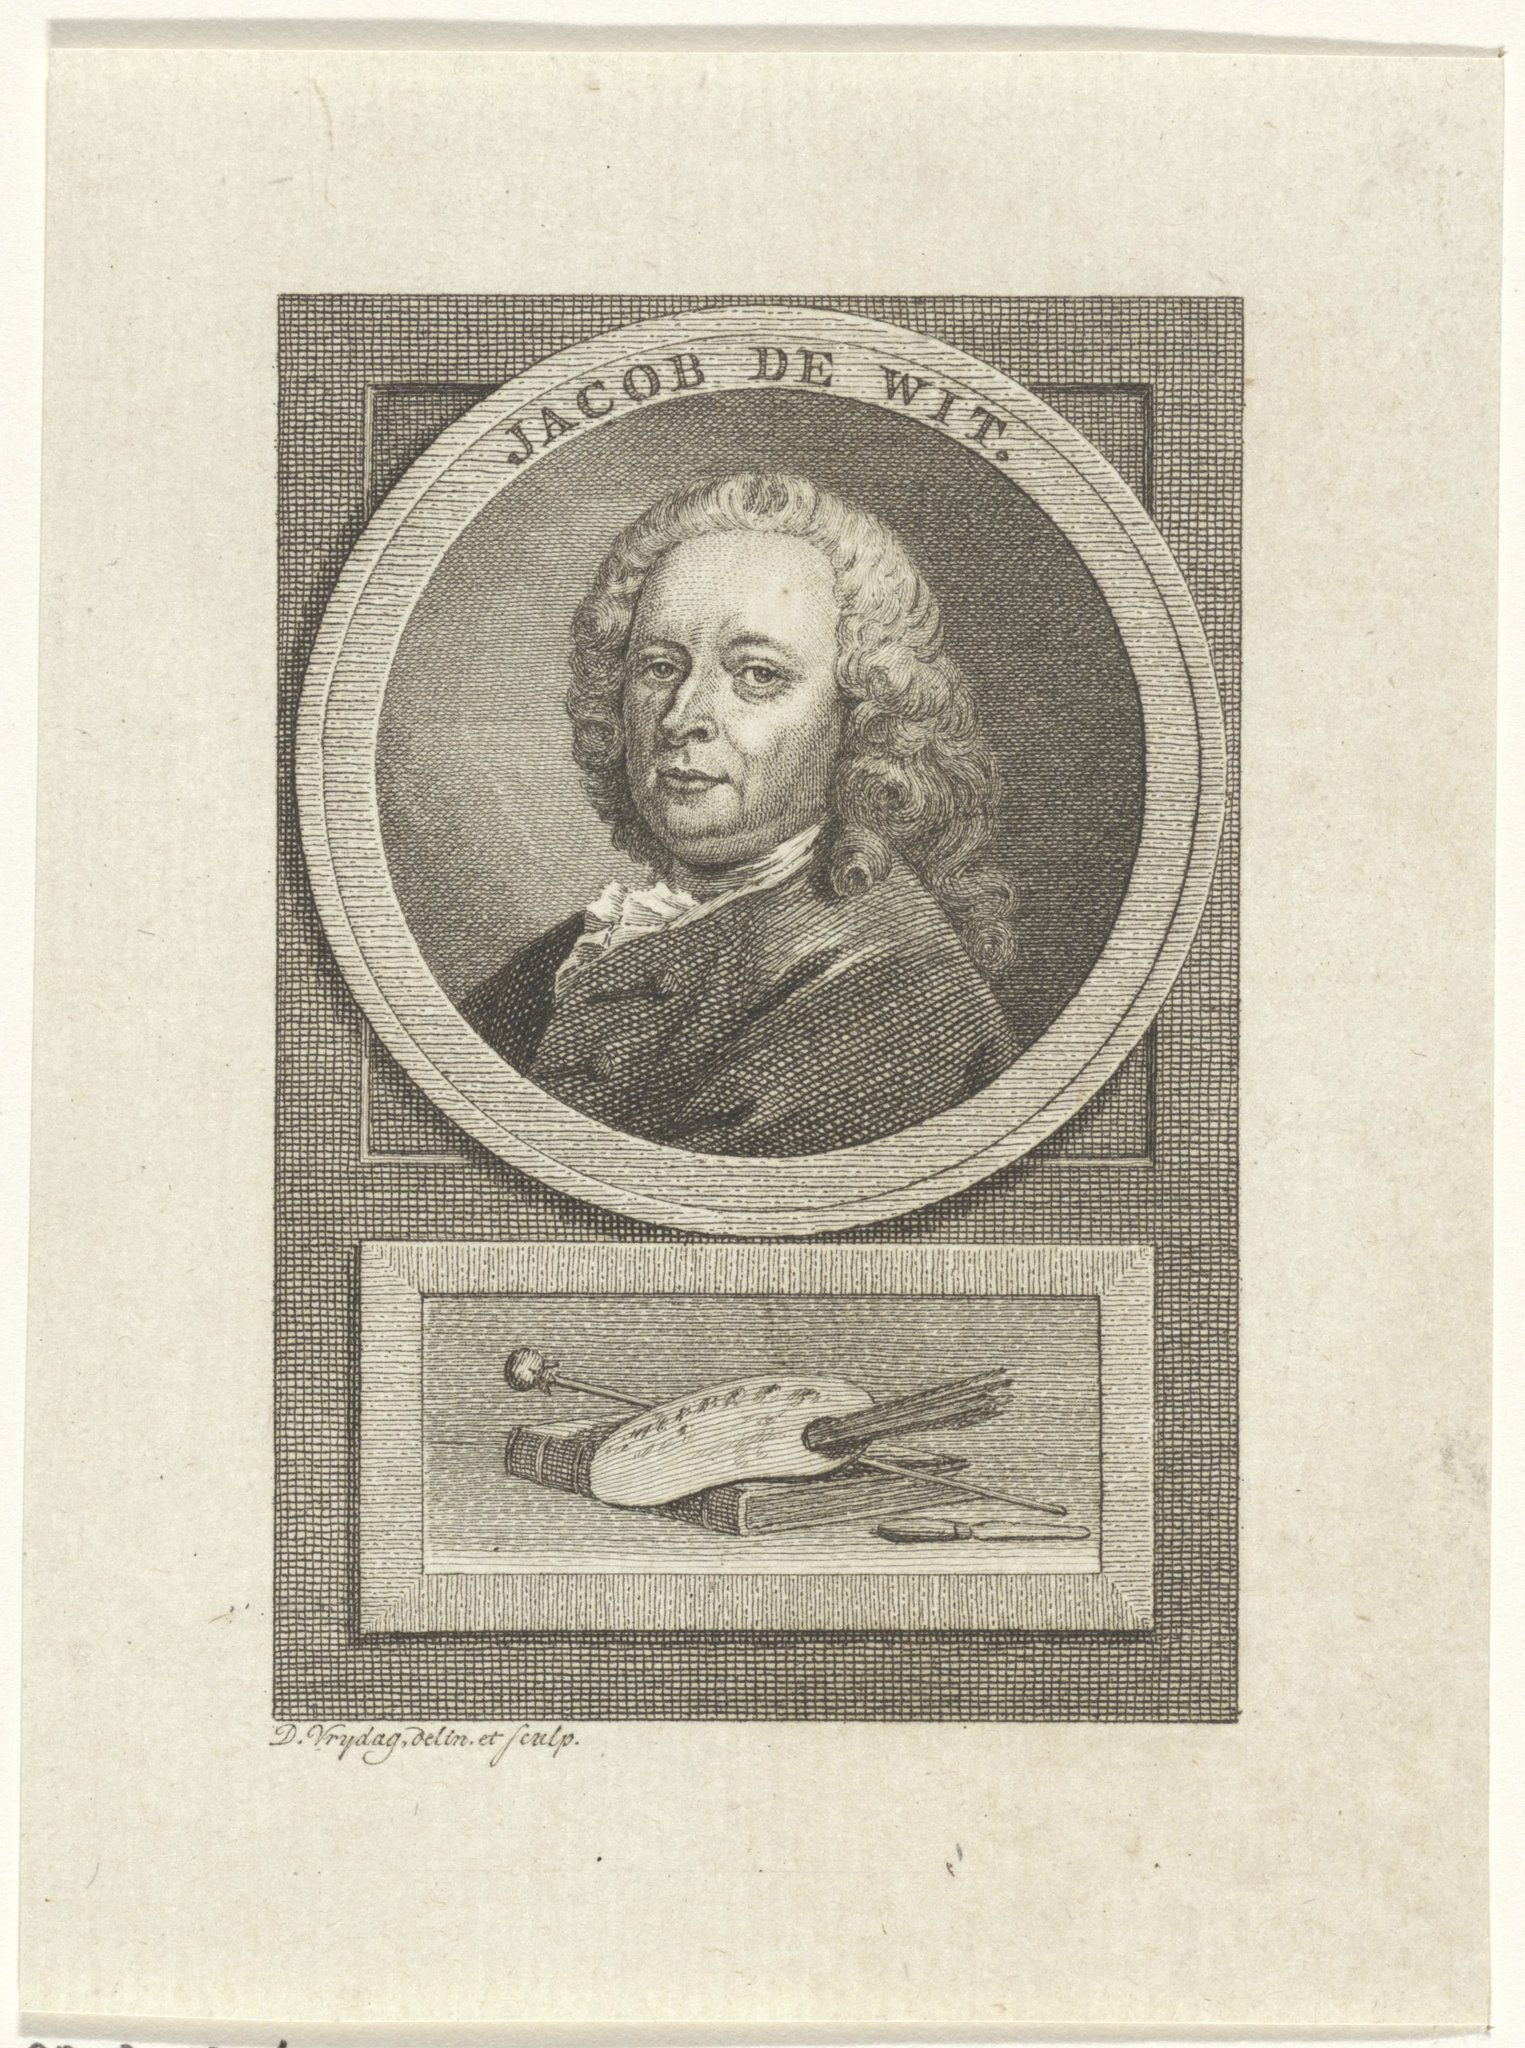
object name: print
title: Portret van Jacob de Wit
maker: daniël vrijdag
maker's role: draughtsman, print maker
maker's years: 1765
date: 1783-1795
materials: paper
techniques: engraving, etching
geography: amsterdam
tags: painter, print maker, draughtsman, jacob de wit, palette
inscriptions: collector's mark: Lugt 2228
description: Prent vermoedelijk gebruikt in: Fokke, Jan. Geschiedenissen der Vereenigde Nederlanden voor de vaderlandsche jeugd Ie-XXVste deel. Amsterdam: Johannes Allart, 1783-1795.